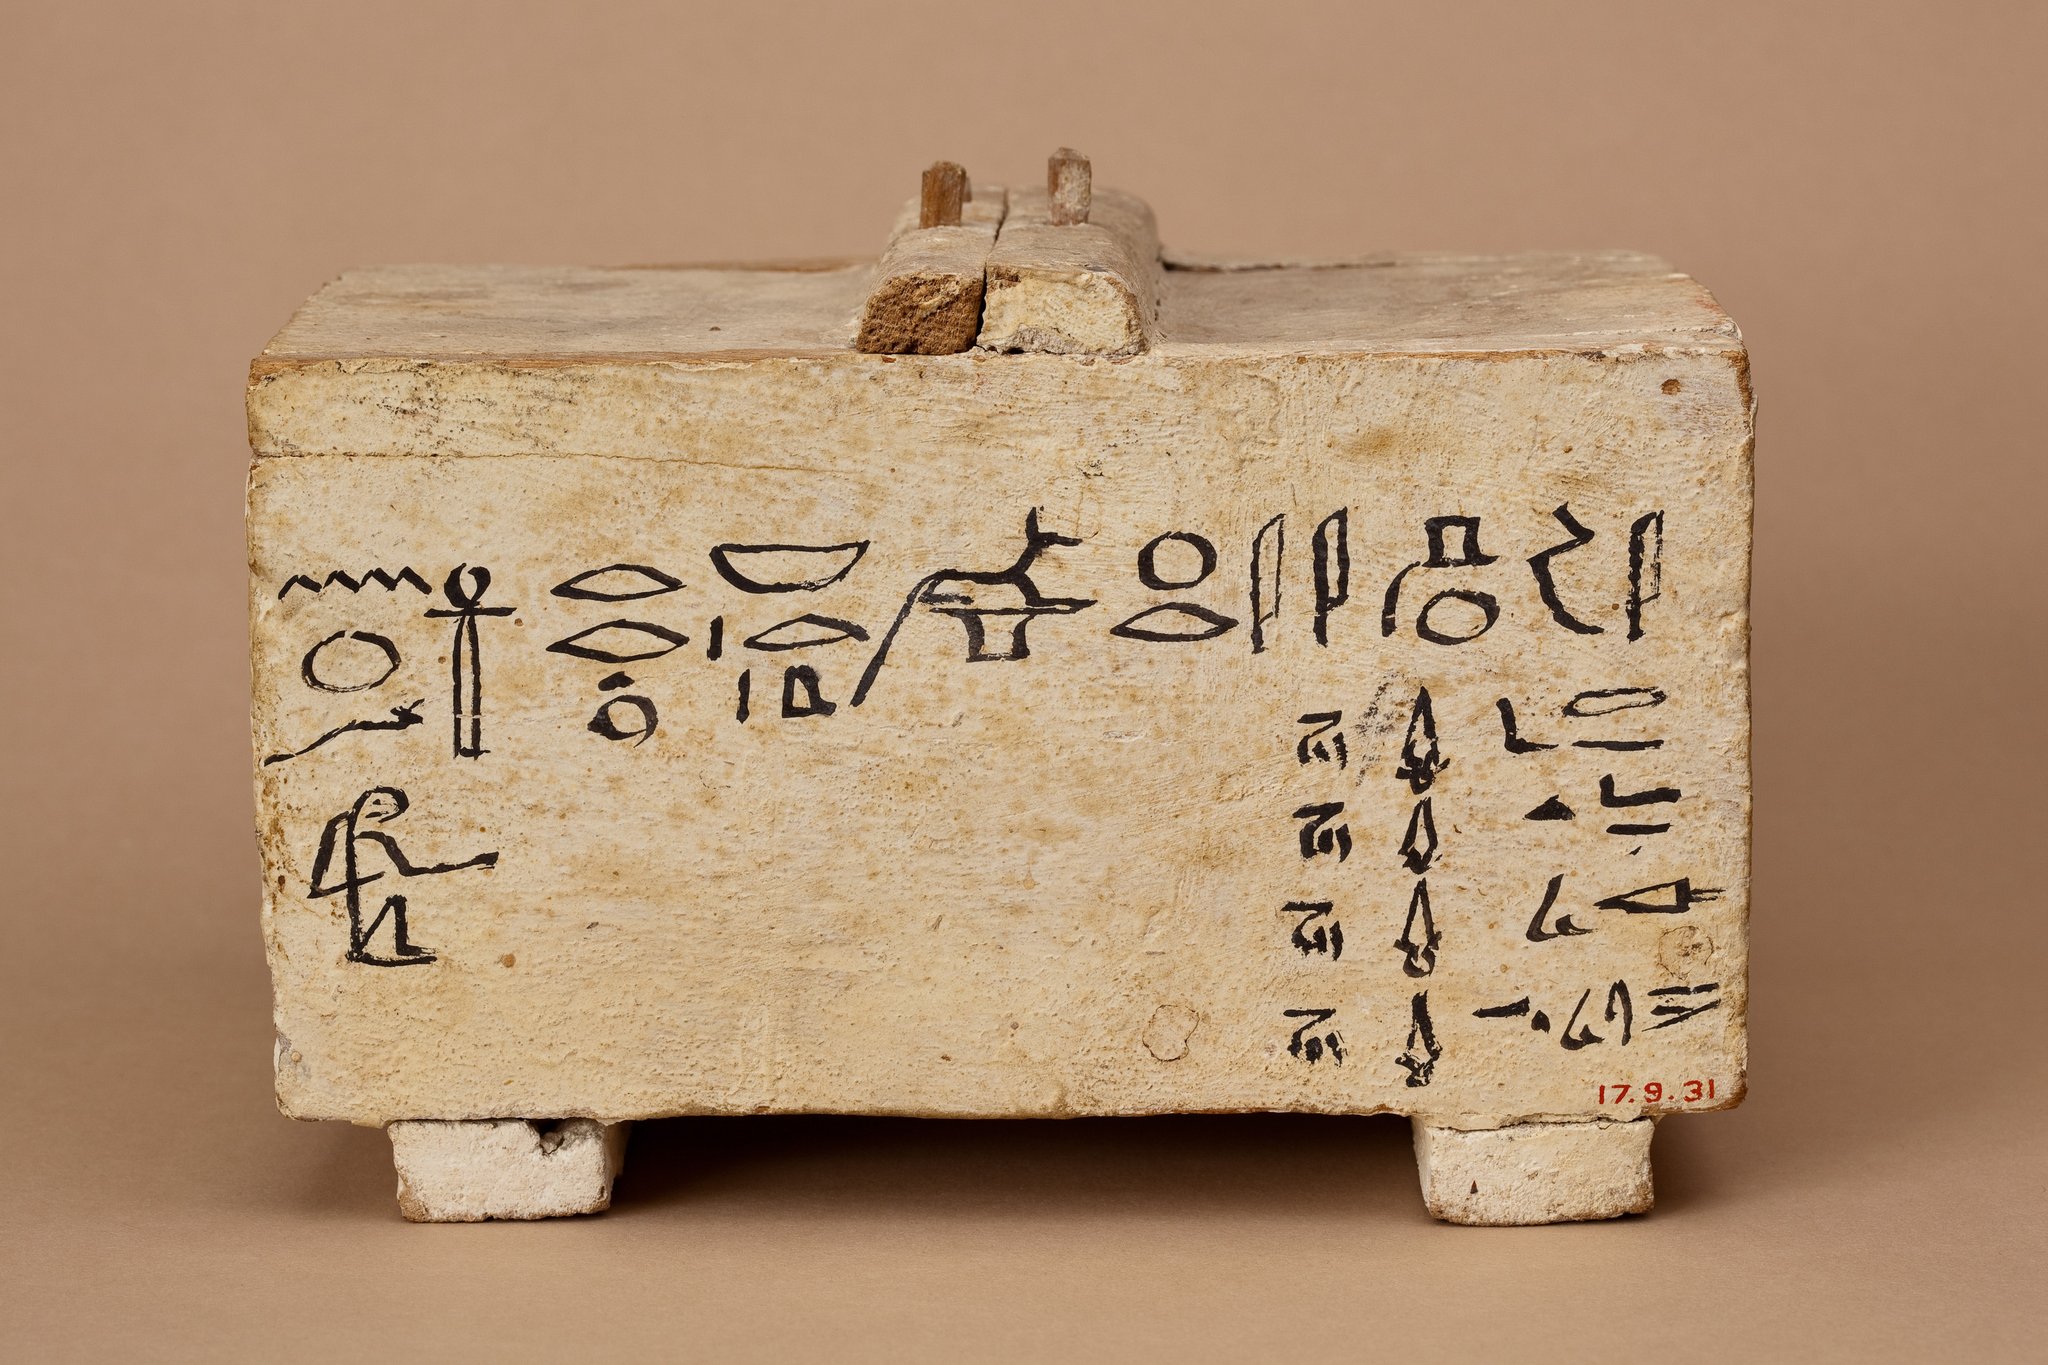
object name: carpenter's chest, ankhef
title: Carpenter's chest of Ankhef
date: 1981-1802 BCE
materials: paint, plaster, wood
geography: egypt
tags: hieroglyphs